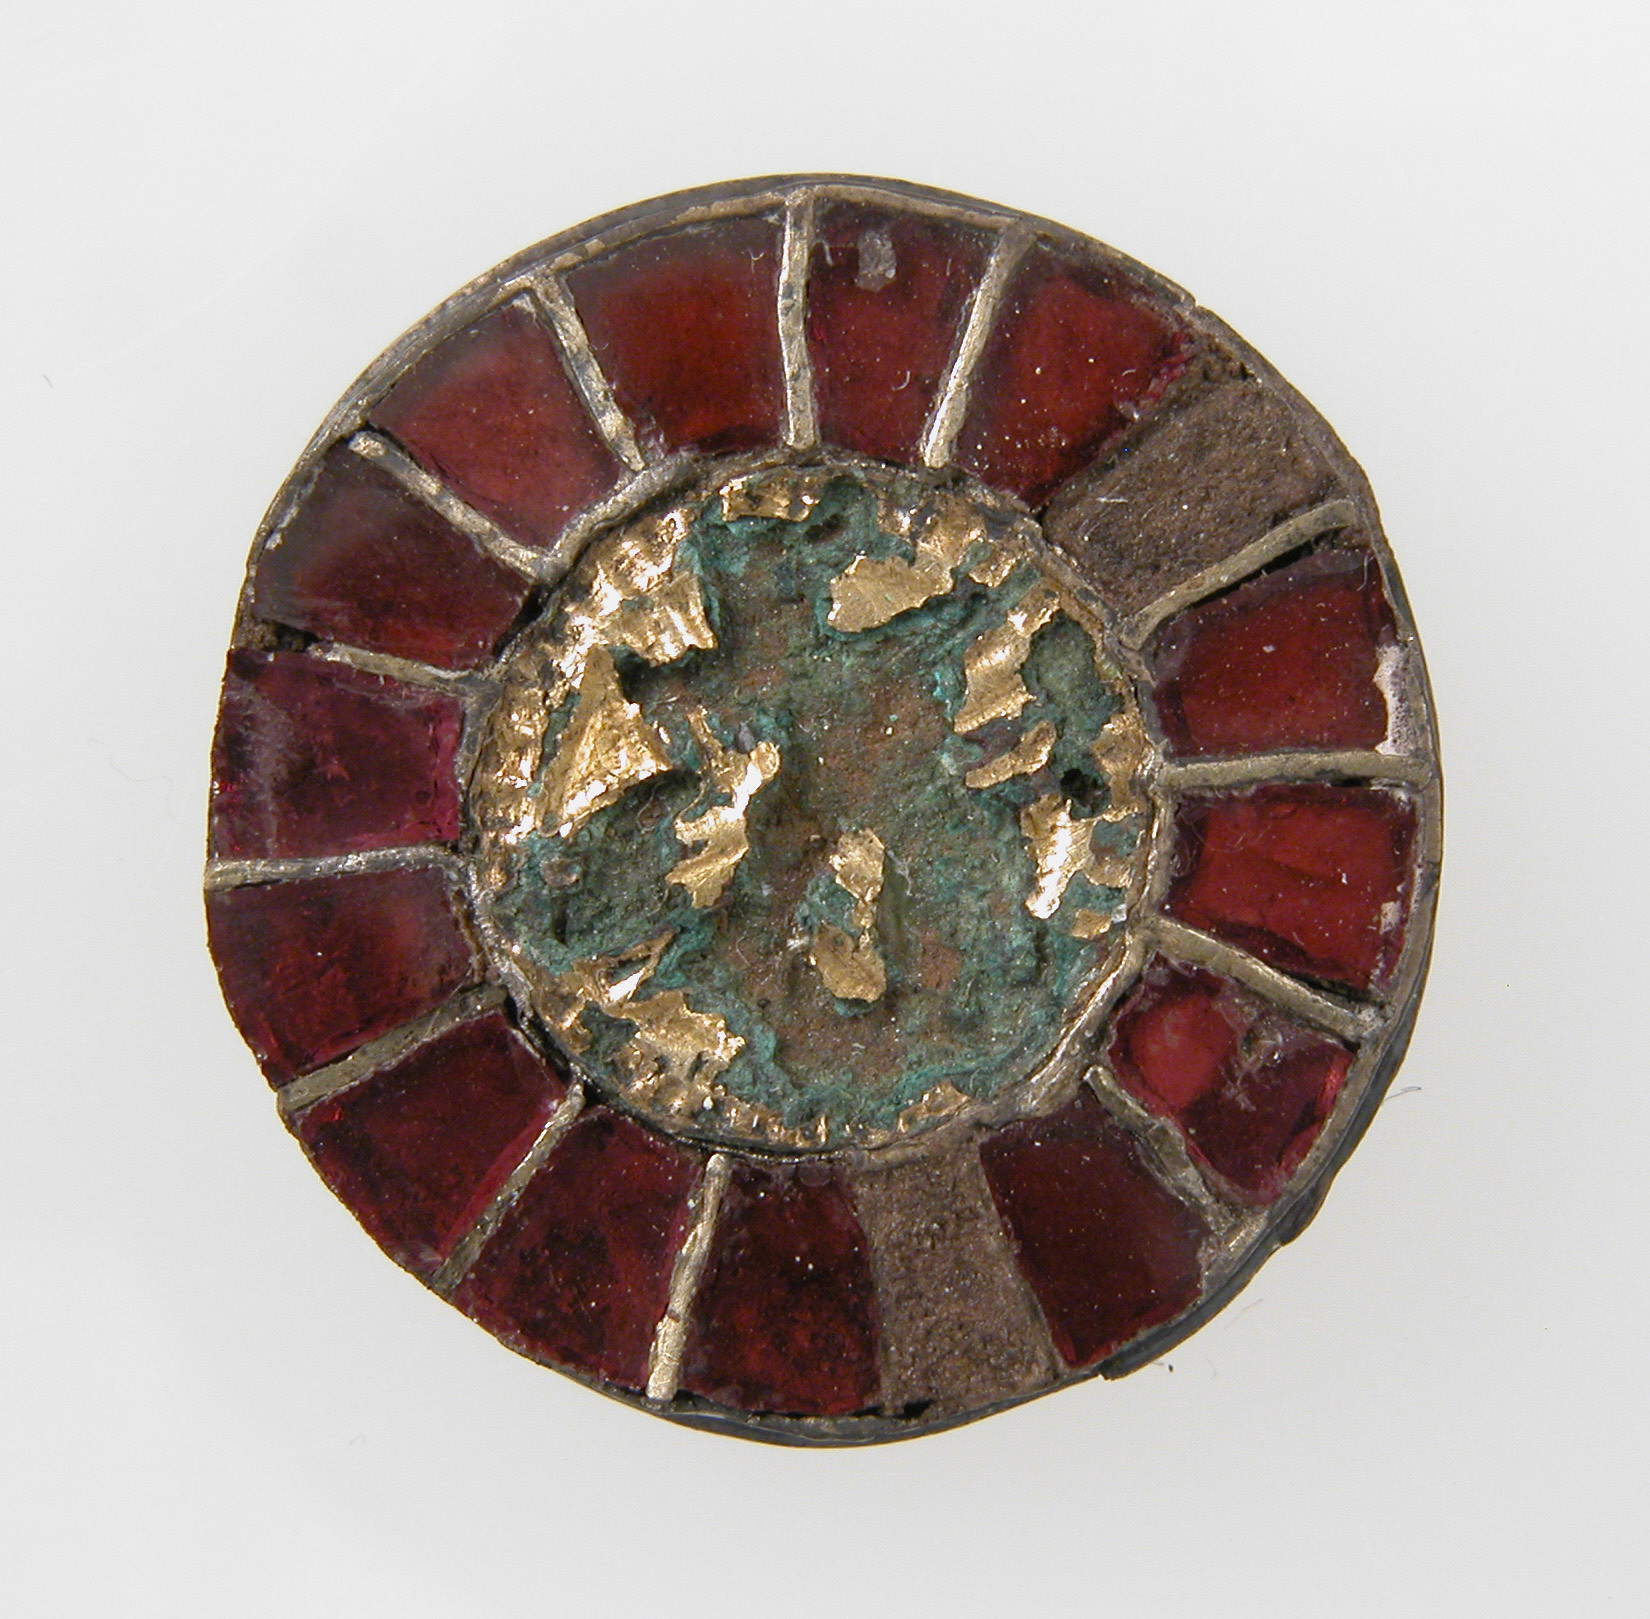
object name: brooch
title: Disk Brooch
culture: frankish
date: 501-600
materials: gemstone, gilt, glass, iron, paste, silver